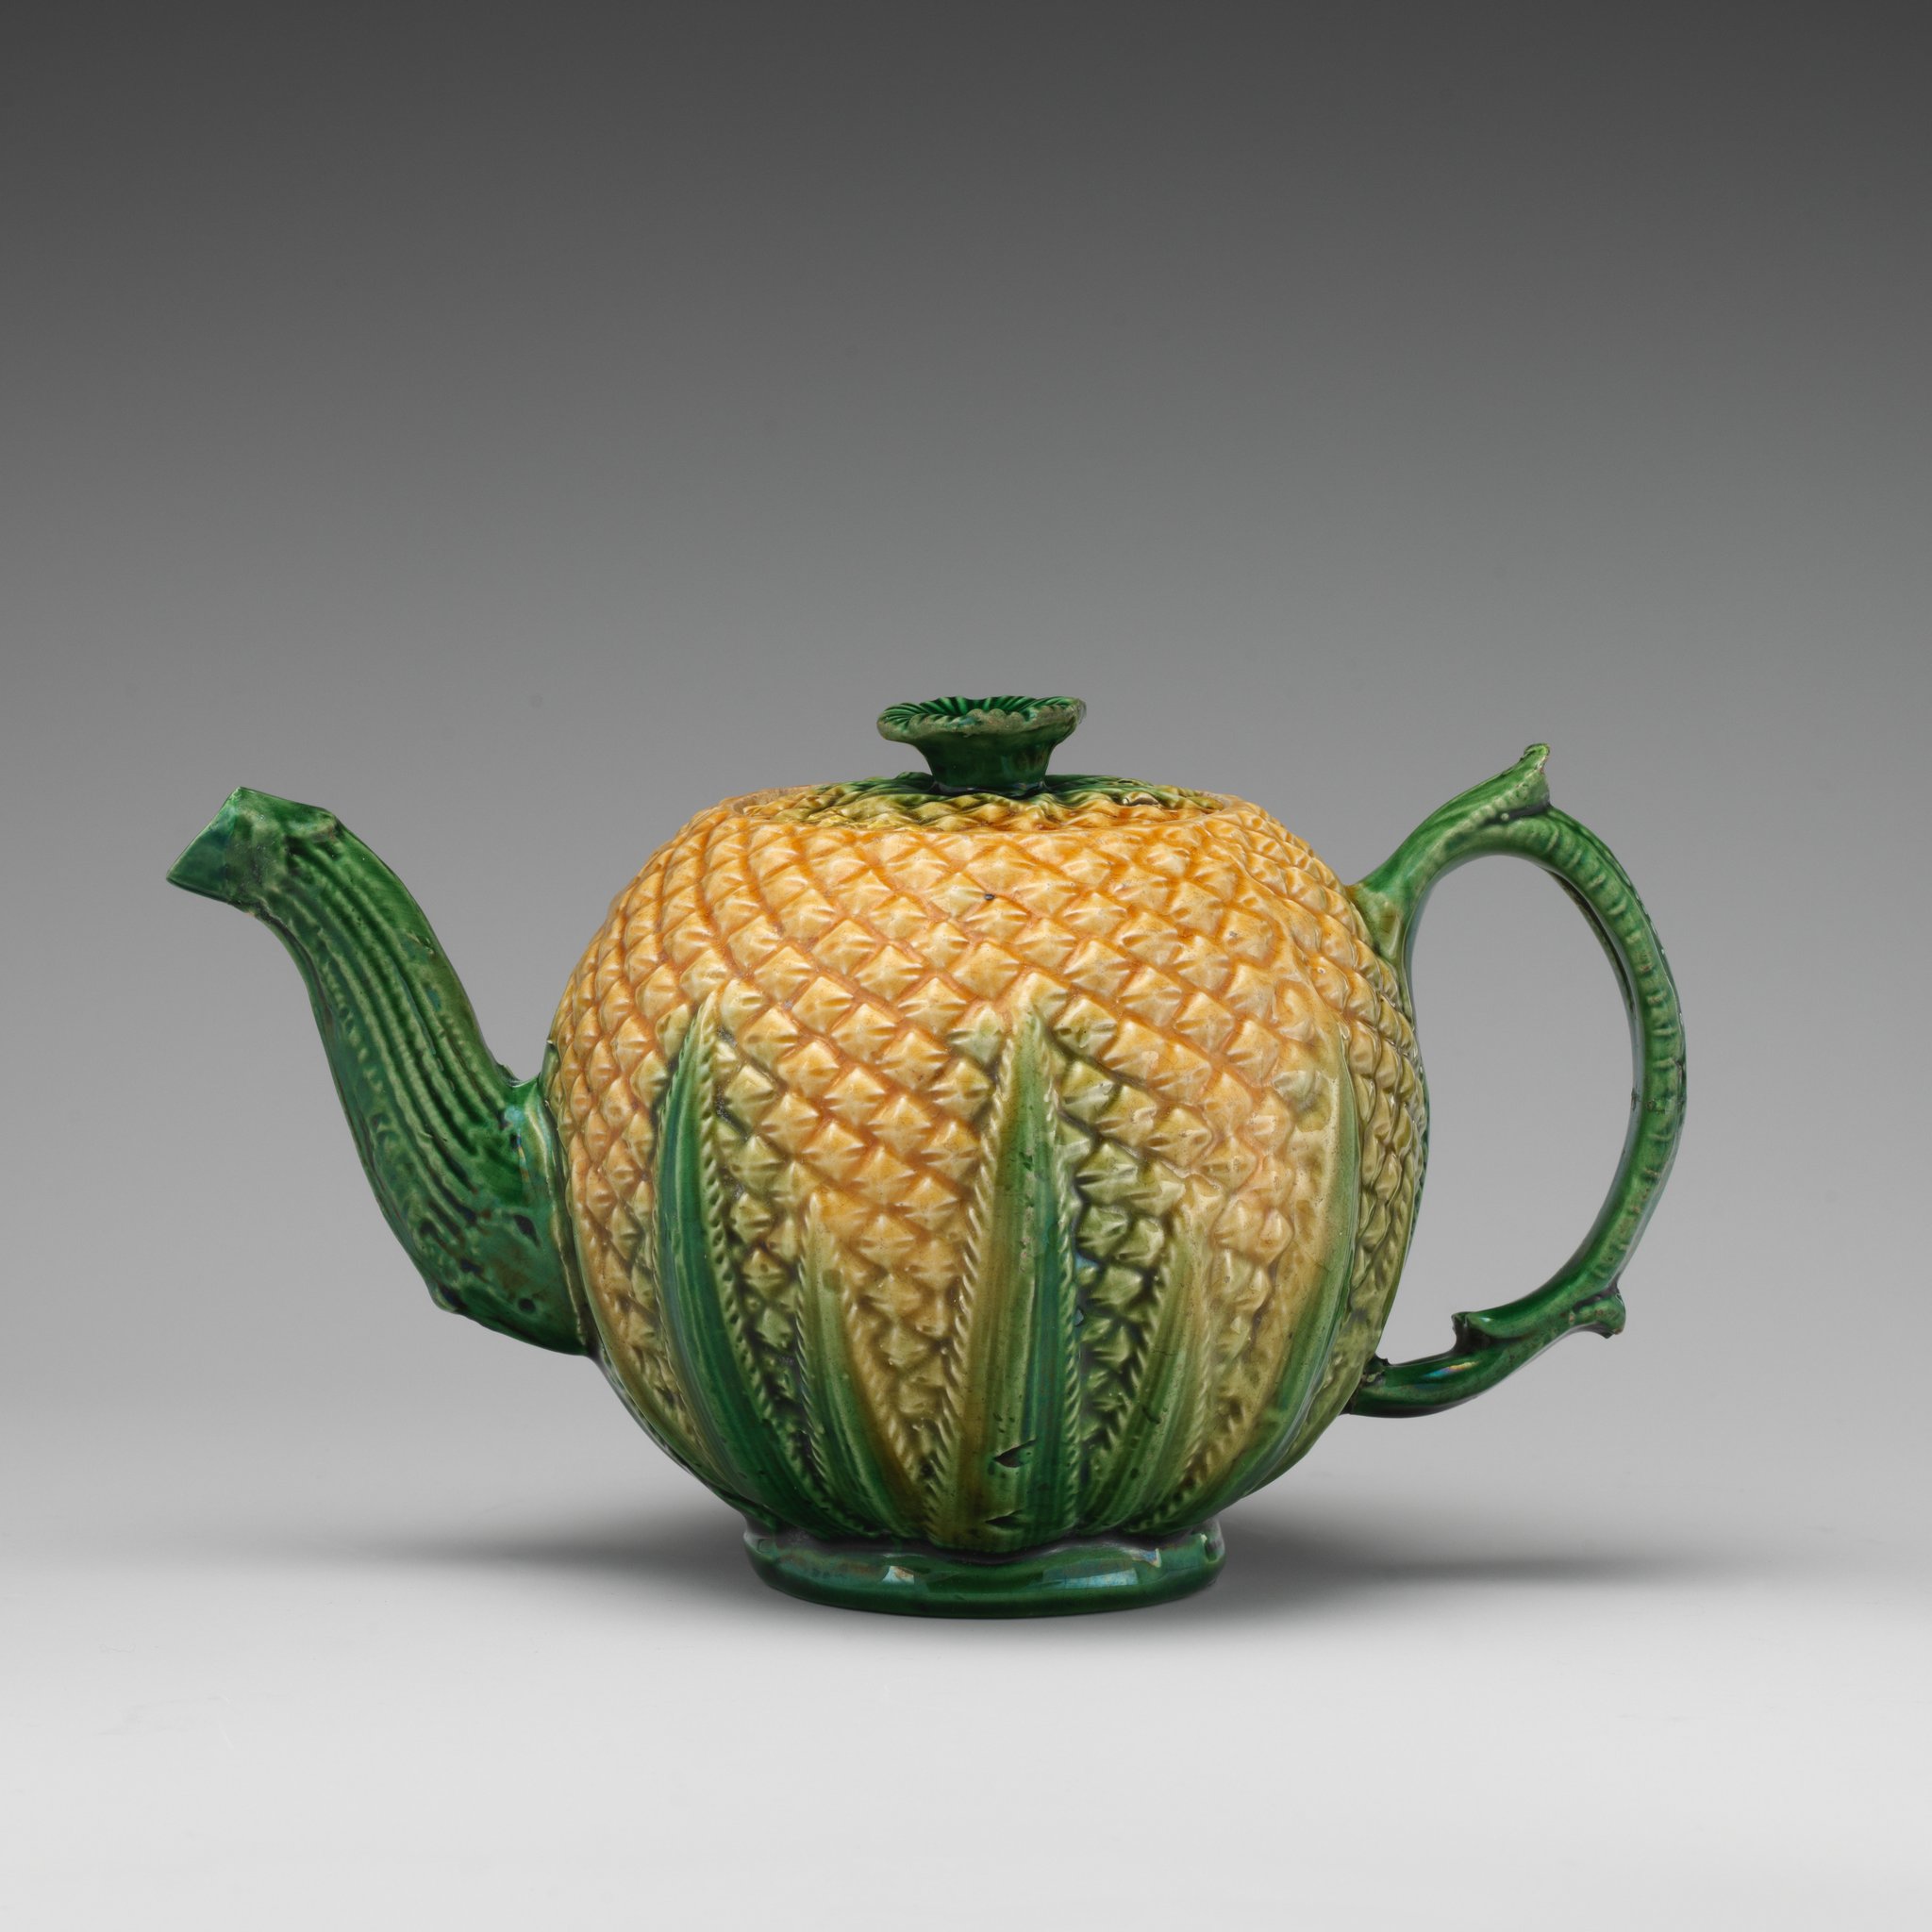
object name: teapot with cover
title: Teapot in the form of a pineapple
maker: whieldon type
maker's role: maker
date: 1750-1770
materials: earthenware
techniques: glazing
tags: fruit